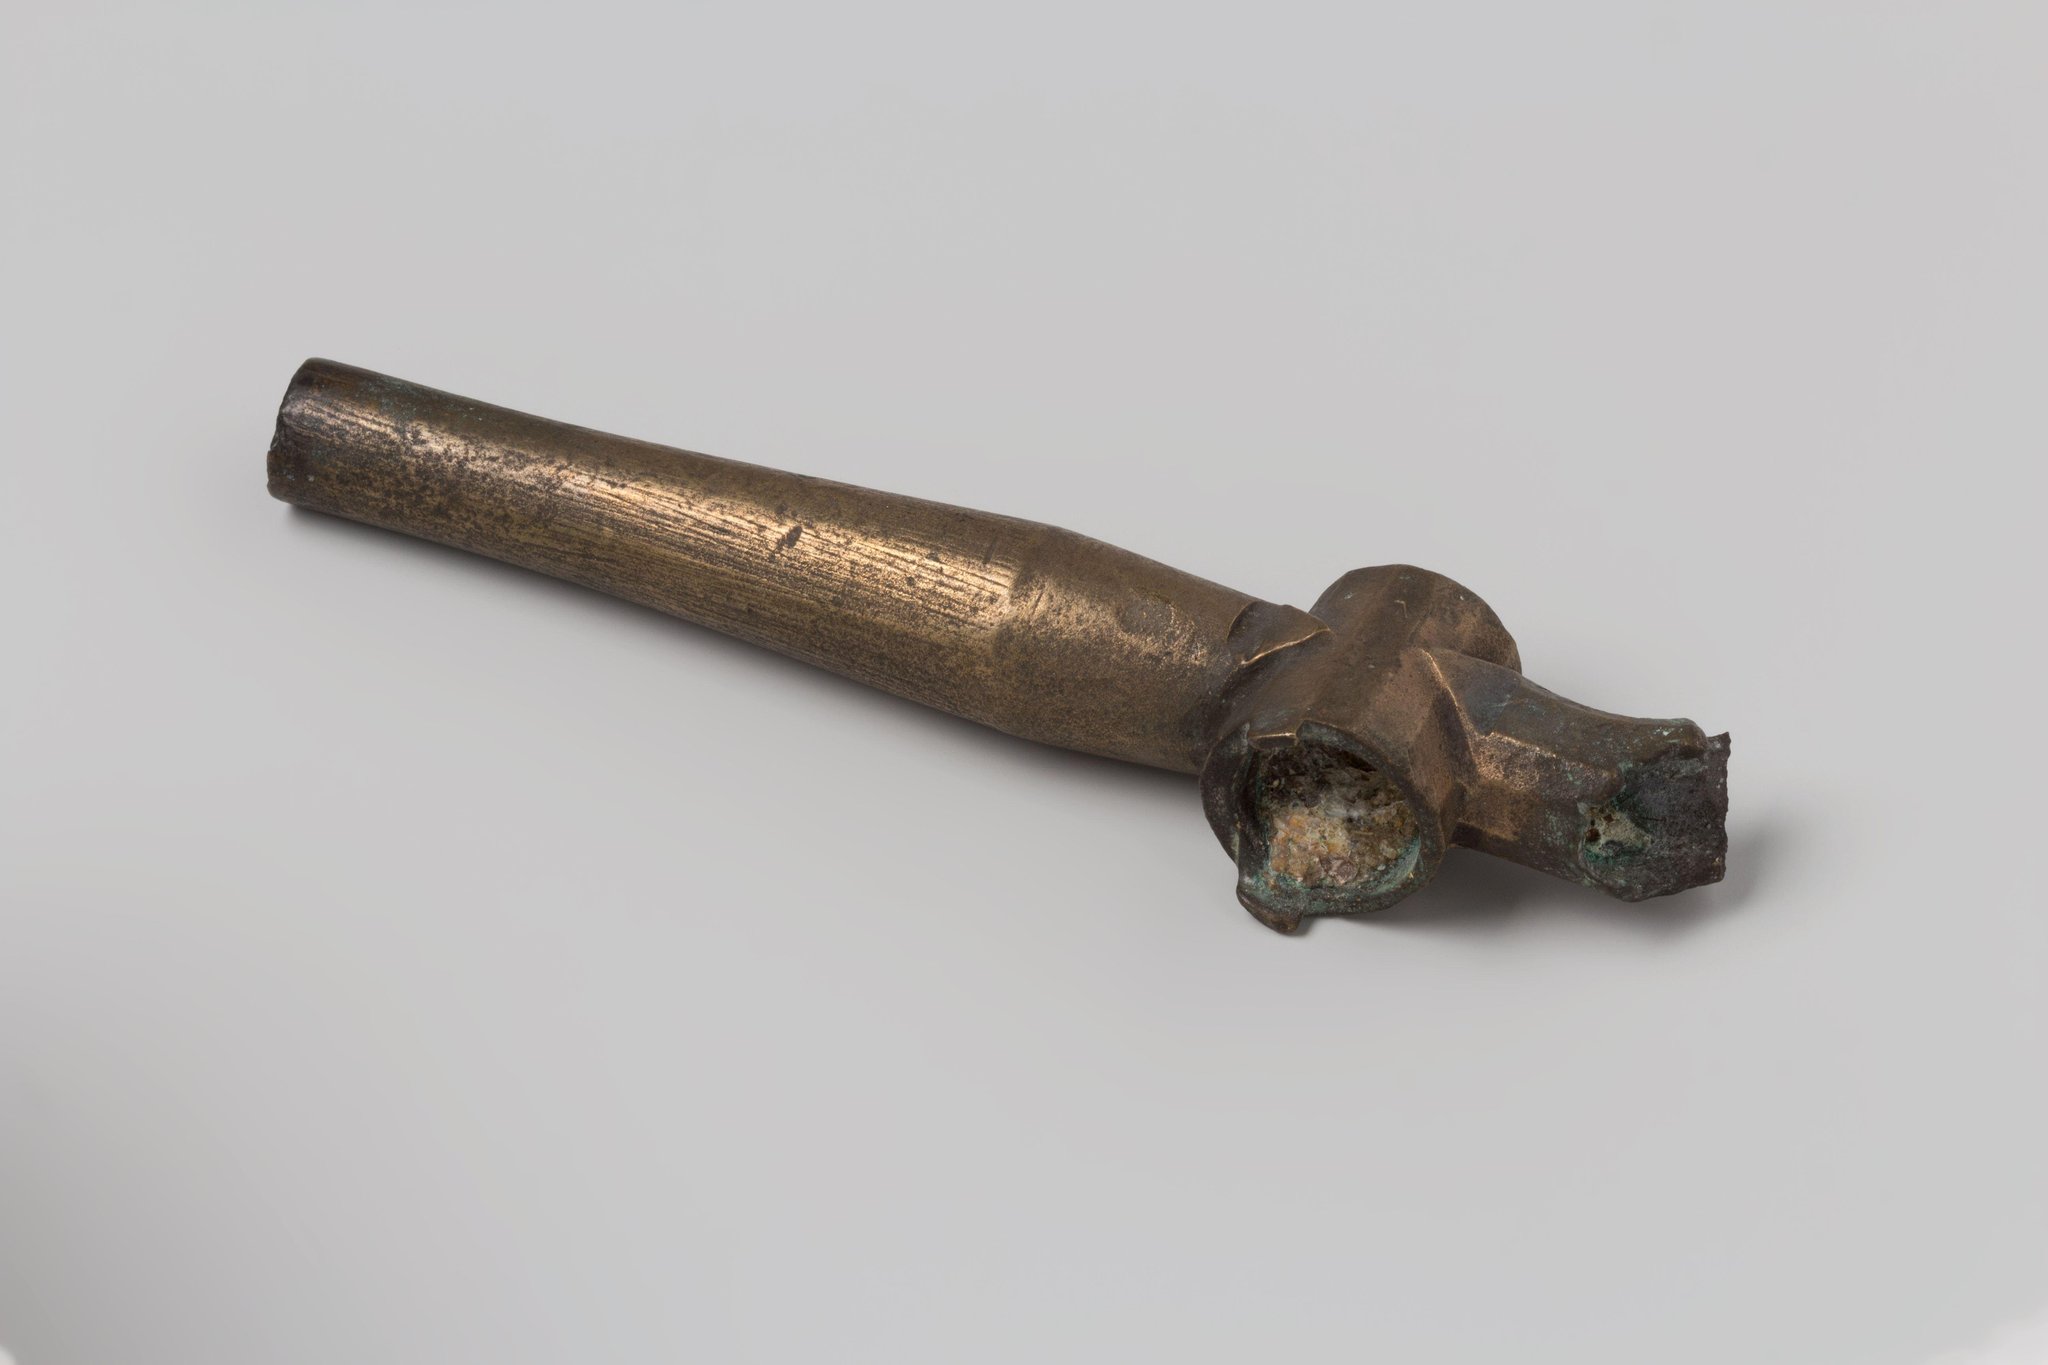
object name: tap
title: Onderdeel kraan uit het wrak van de Oost-Indiëvaarder Hollandia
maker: Anonymous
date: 1700-1743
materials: copper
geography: netherlands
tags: verenigde oostindische compagnie, hollandia (schip), annet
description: Tap, part of tap; id. NG 1979-521H, mouth broken off.